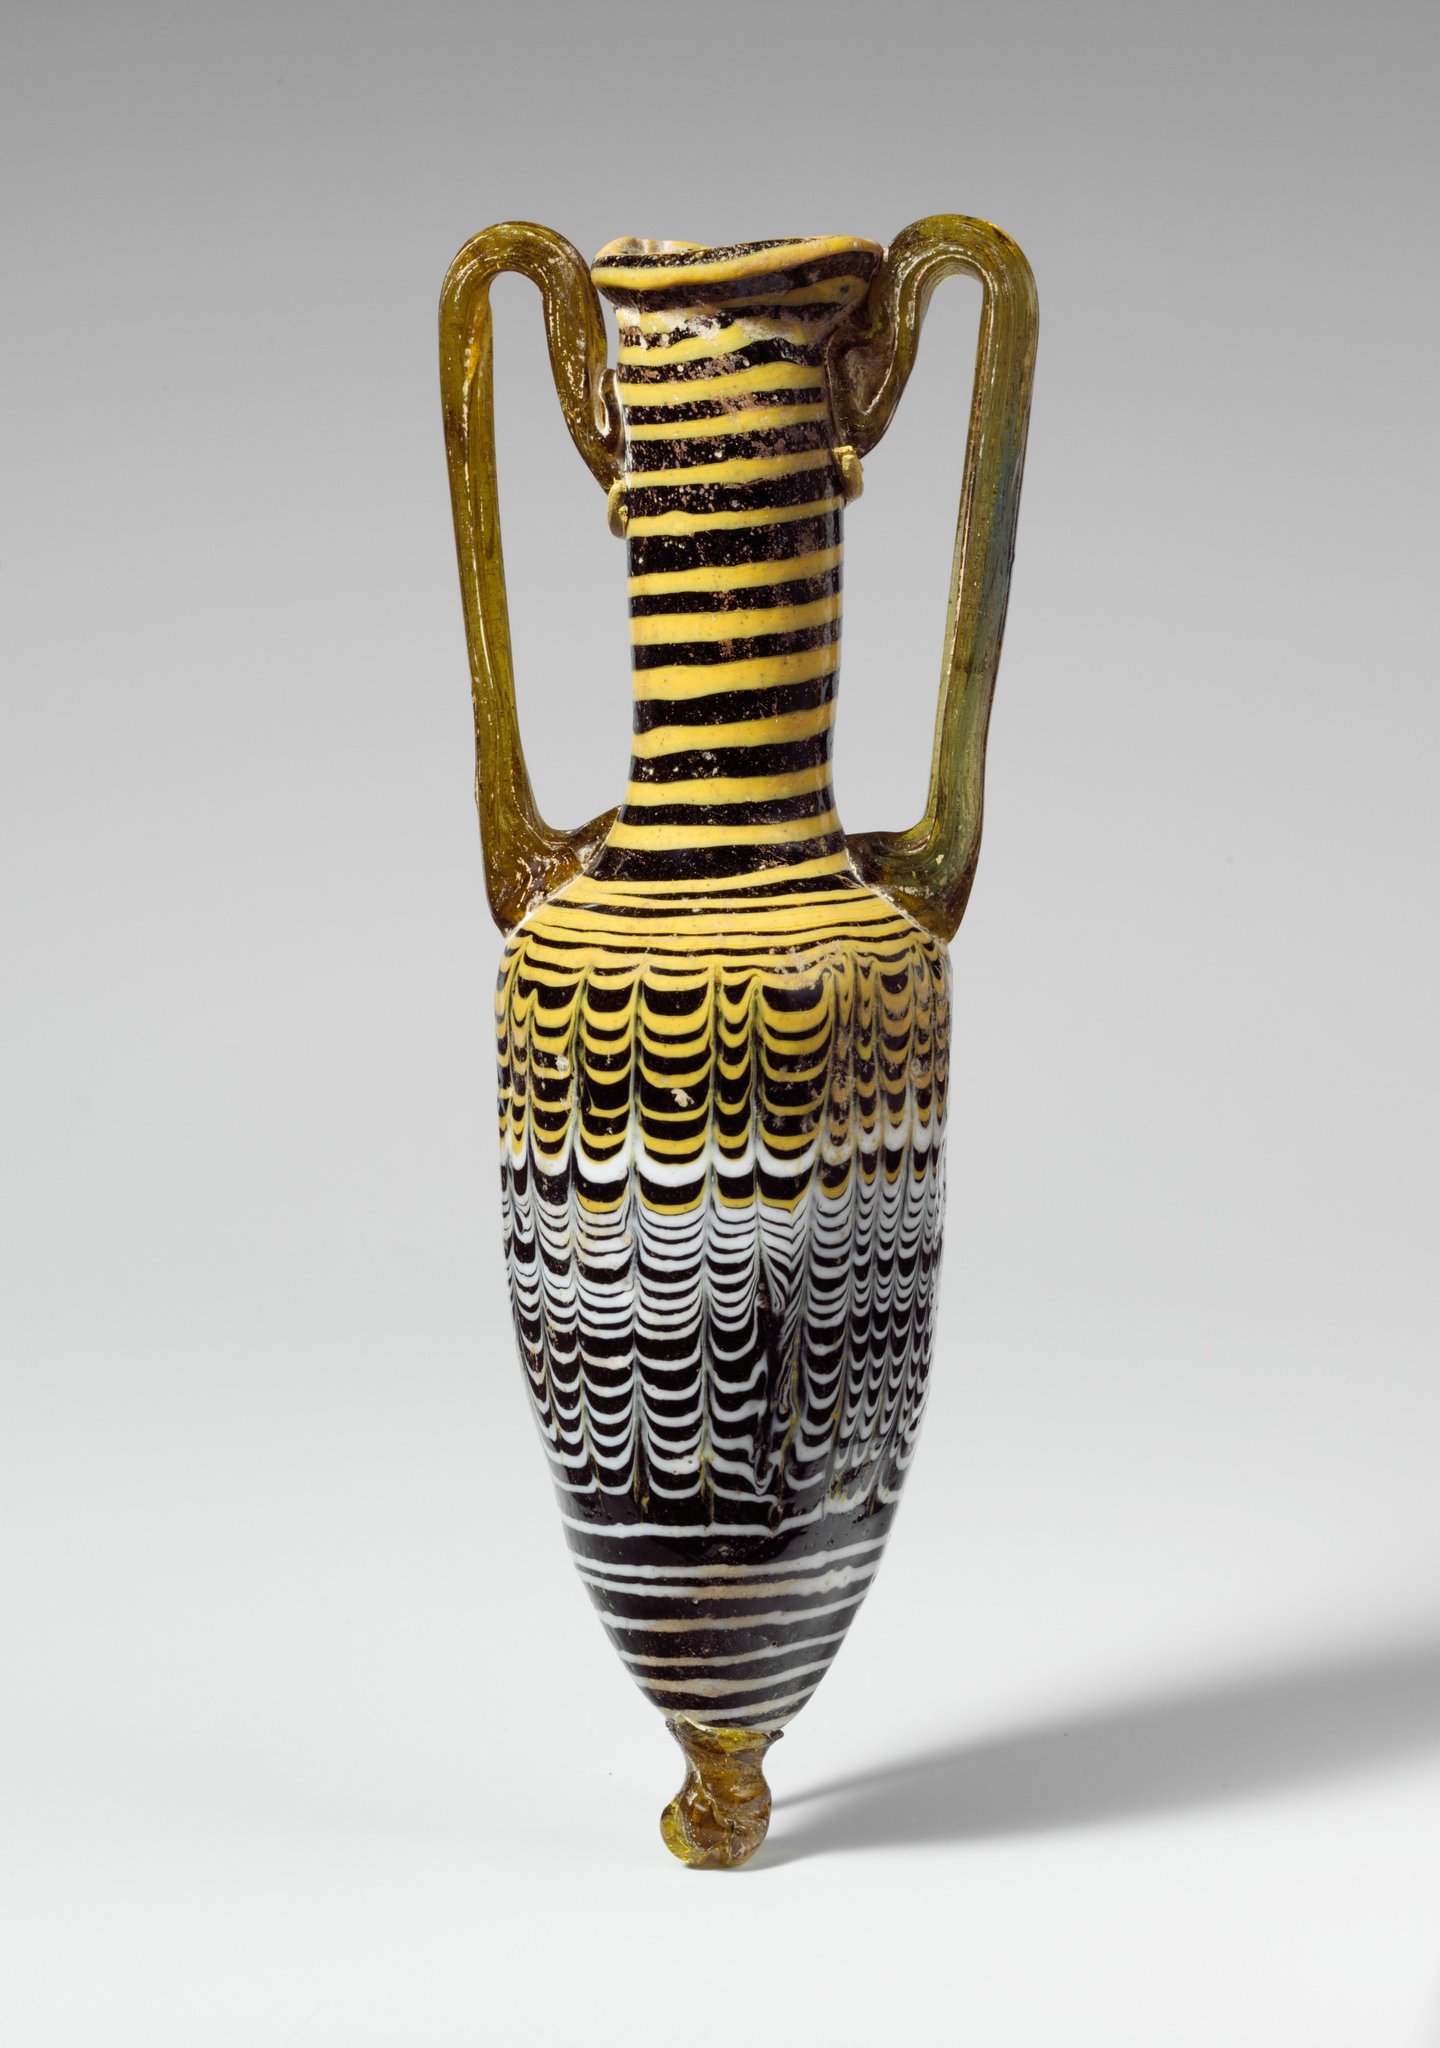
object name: amphoriskos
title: Glass amphoriskos (perfume bottle)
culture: greek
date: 200-35 BCE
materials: glass